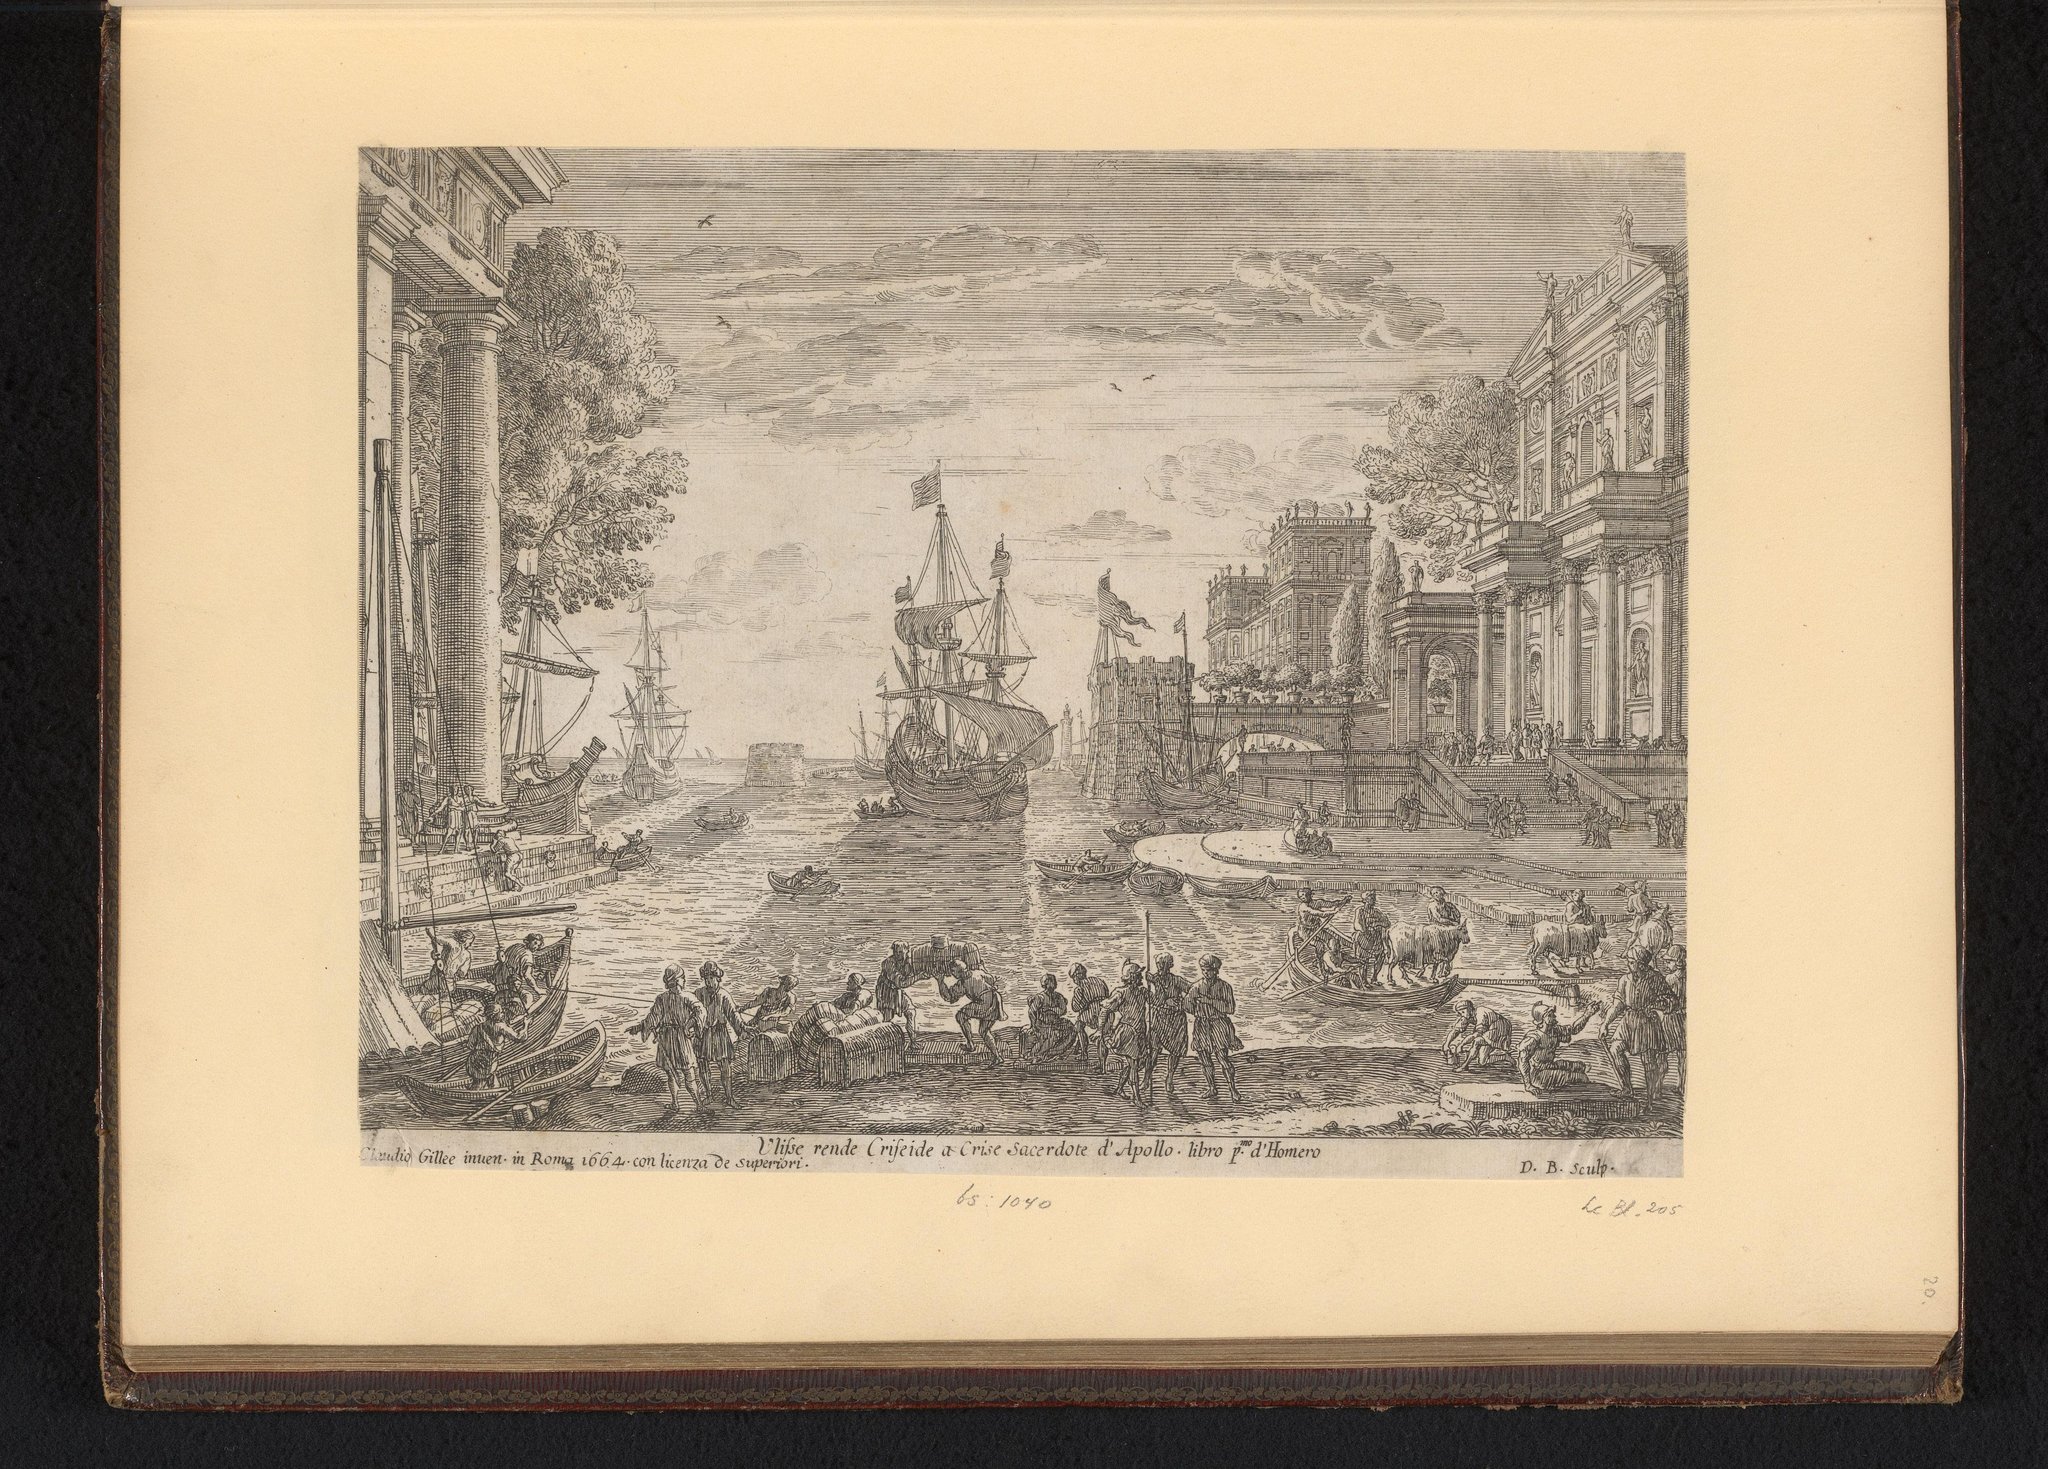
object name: album leaf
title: Ulisse rende Criseide a Crise Sacerdote d' Apollo, libro pmo. d'Homero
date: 1664-1678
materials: paper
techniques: etching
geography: rome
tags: harbour, chryseis is returned to her father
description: Prent maakt mogelijk deel uit van een serie van 200 prenten. Deze serie is onder de titel 'A Collection of two hundred original etchings' voor het eerst uitgegeven door J.M. Greery in 1816.